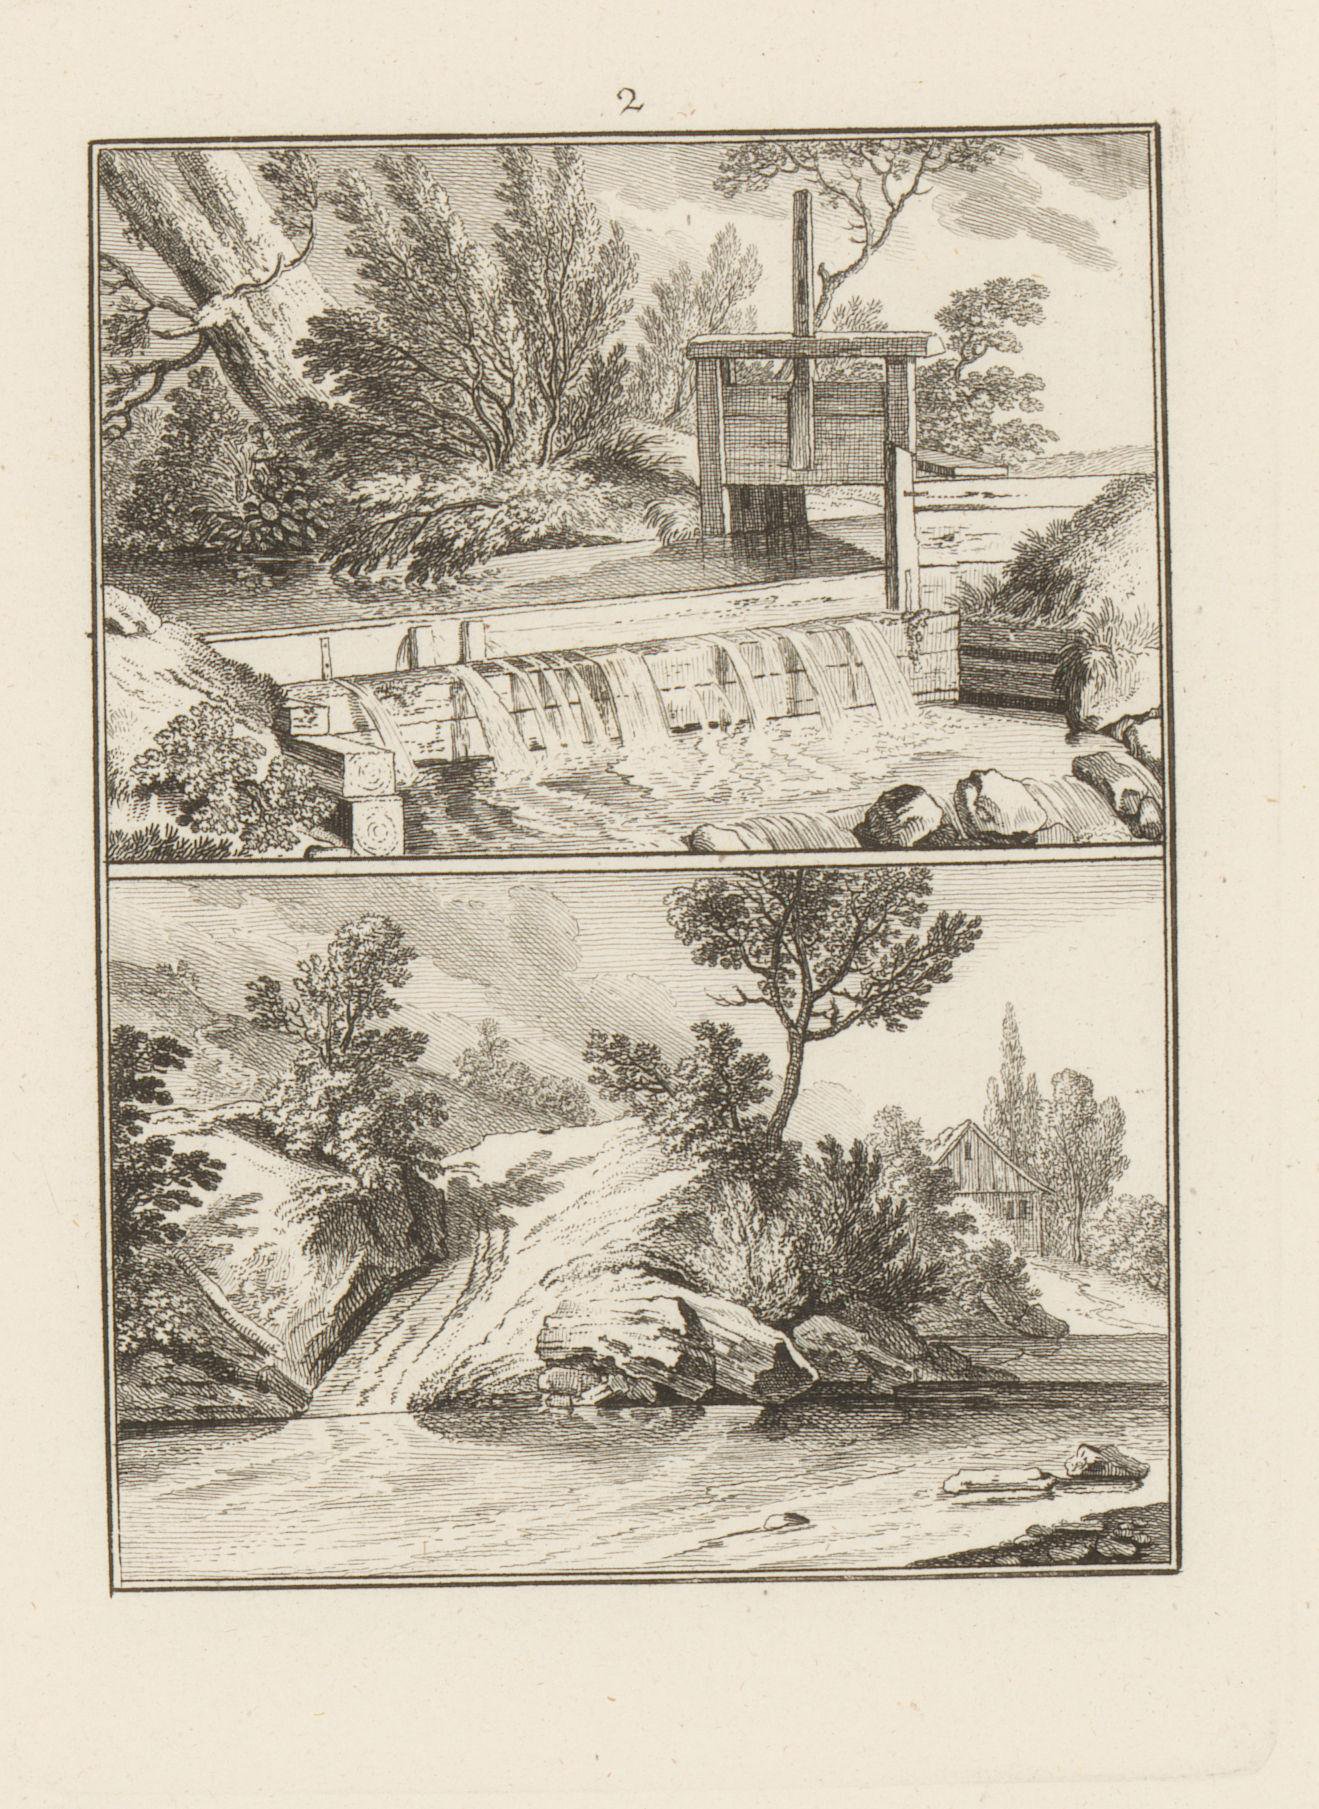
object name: print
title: Landschappen met water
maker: johann rudolph schellenberg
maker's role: print maker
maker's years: 1740-1806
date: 1781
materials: paper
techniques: etching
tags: landscapes with waters, waterscapes, seascapes (in the temperate zone), lift-lock, canal lock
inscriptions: collector's mark: Lugt 2228